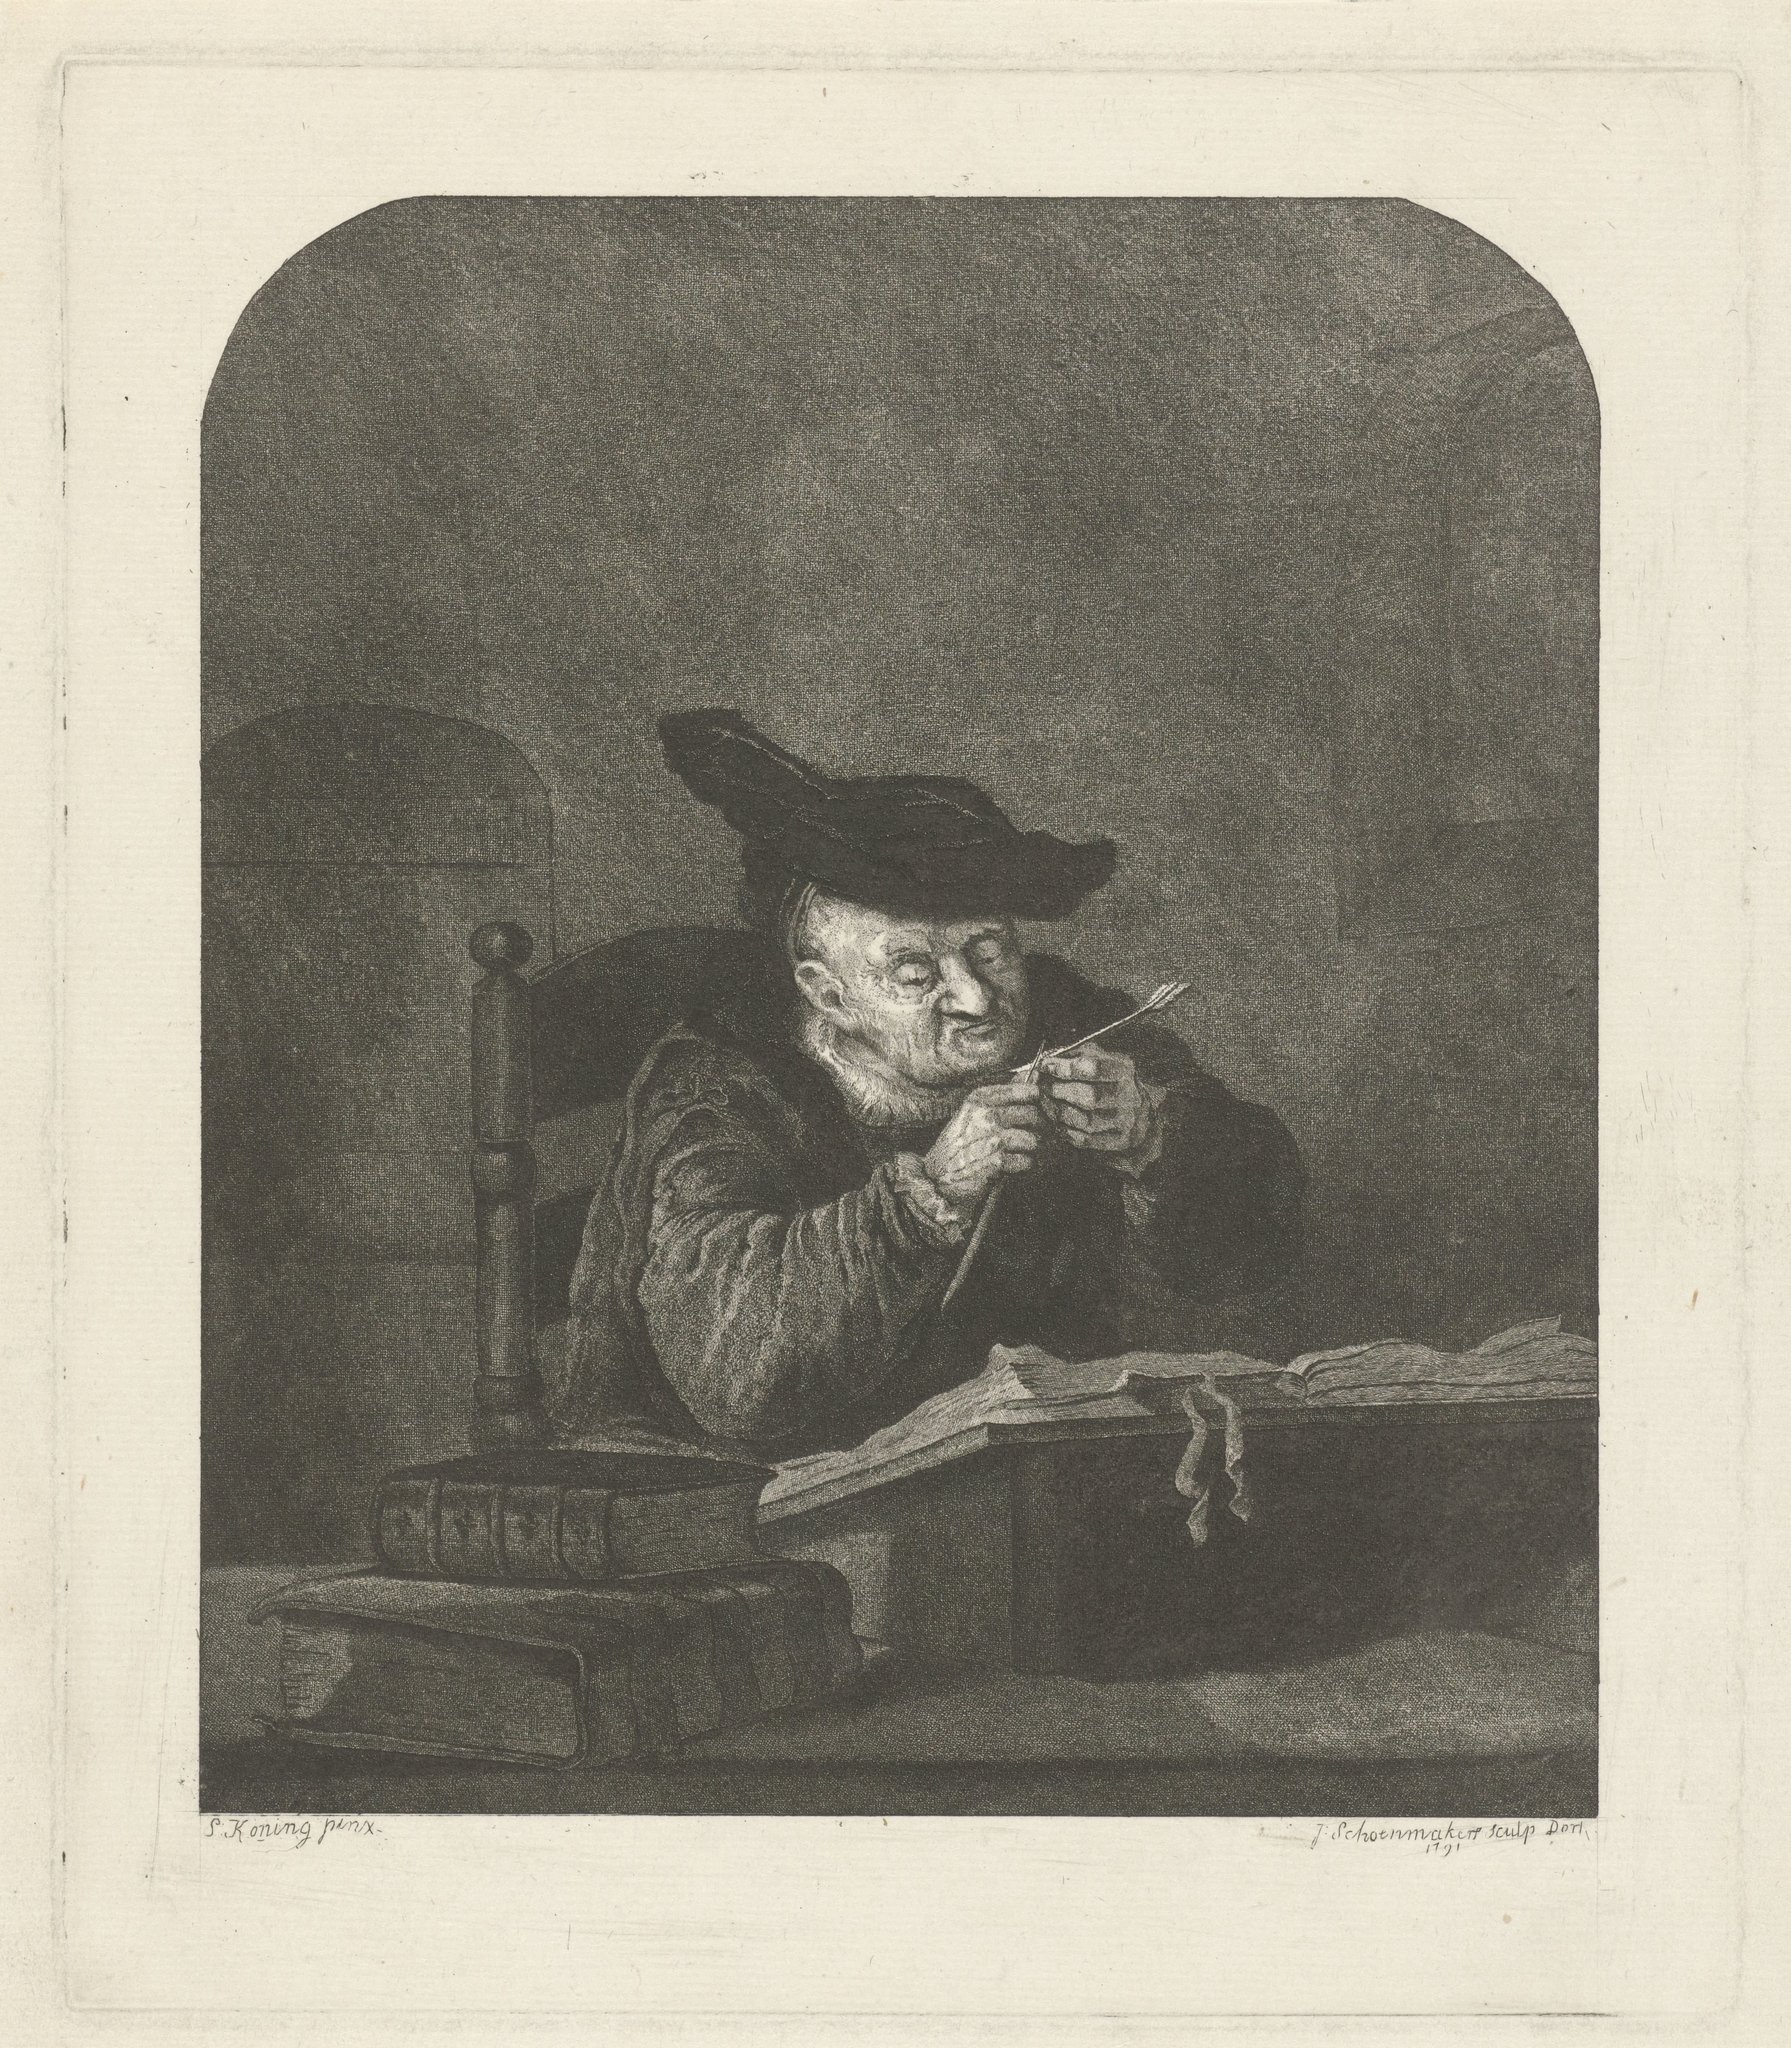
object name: print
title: Pennensnijder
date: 1791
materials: paper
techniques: etching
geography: dordrecht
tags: book, sharpening pen (quill)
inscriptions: collector's mark: Lugt 2228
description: Een oude man zit aan een bureau en snijdt zijn pen. Op het bureau liggen twee dikke boeken en een opengeslagen boek.